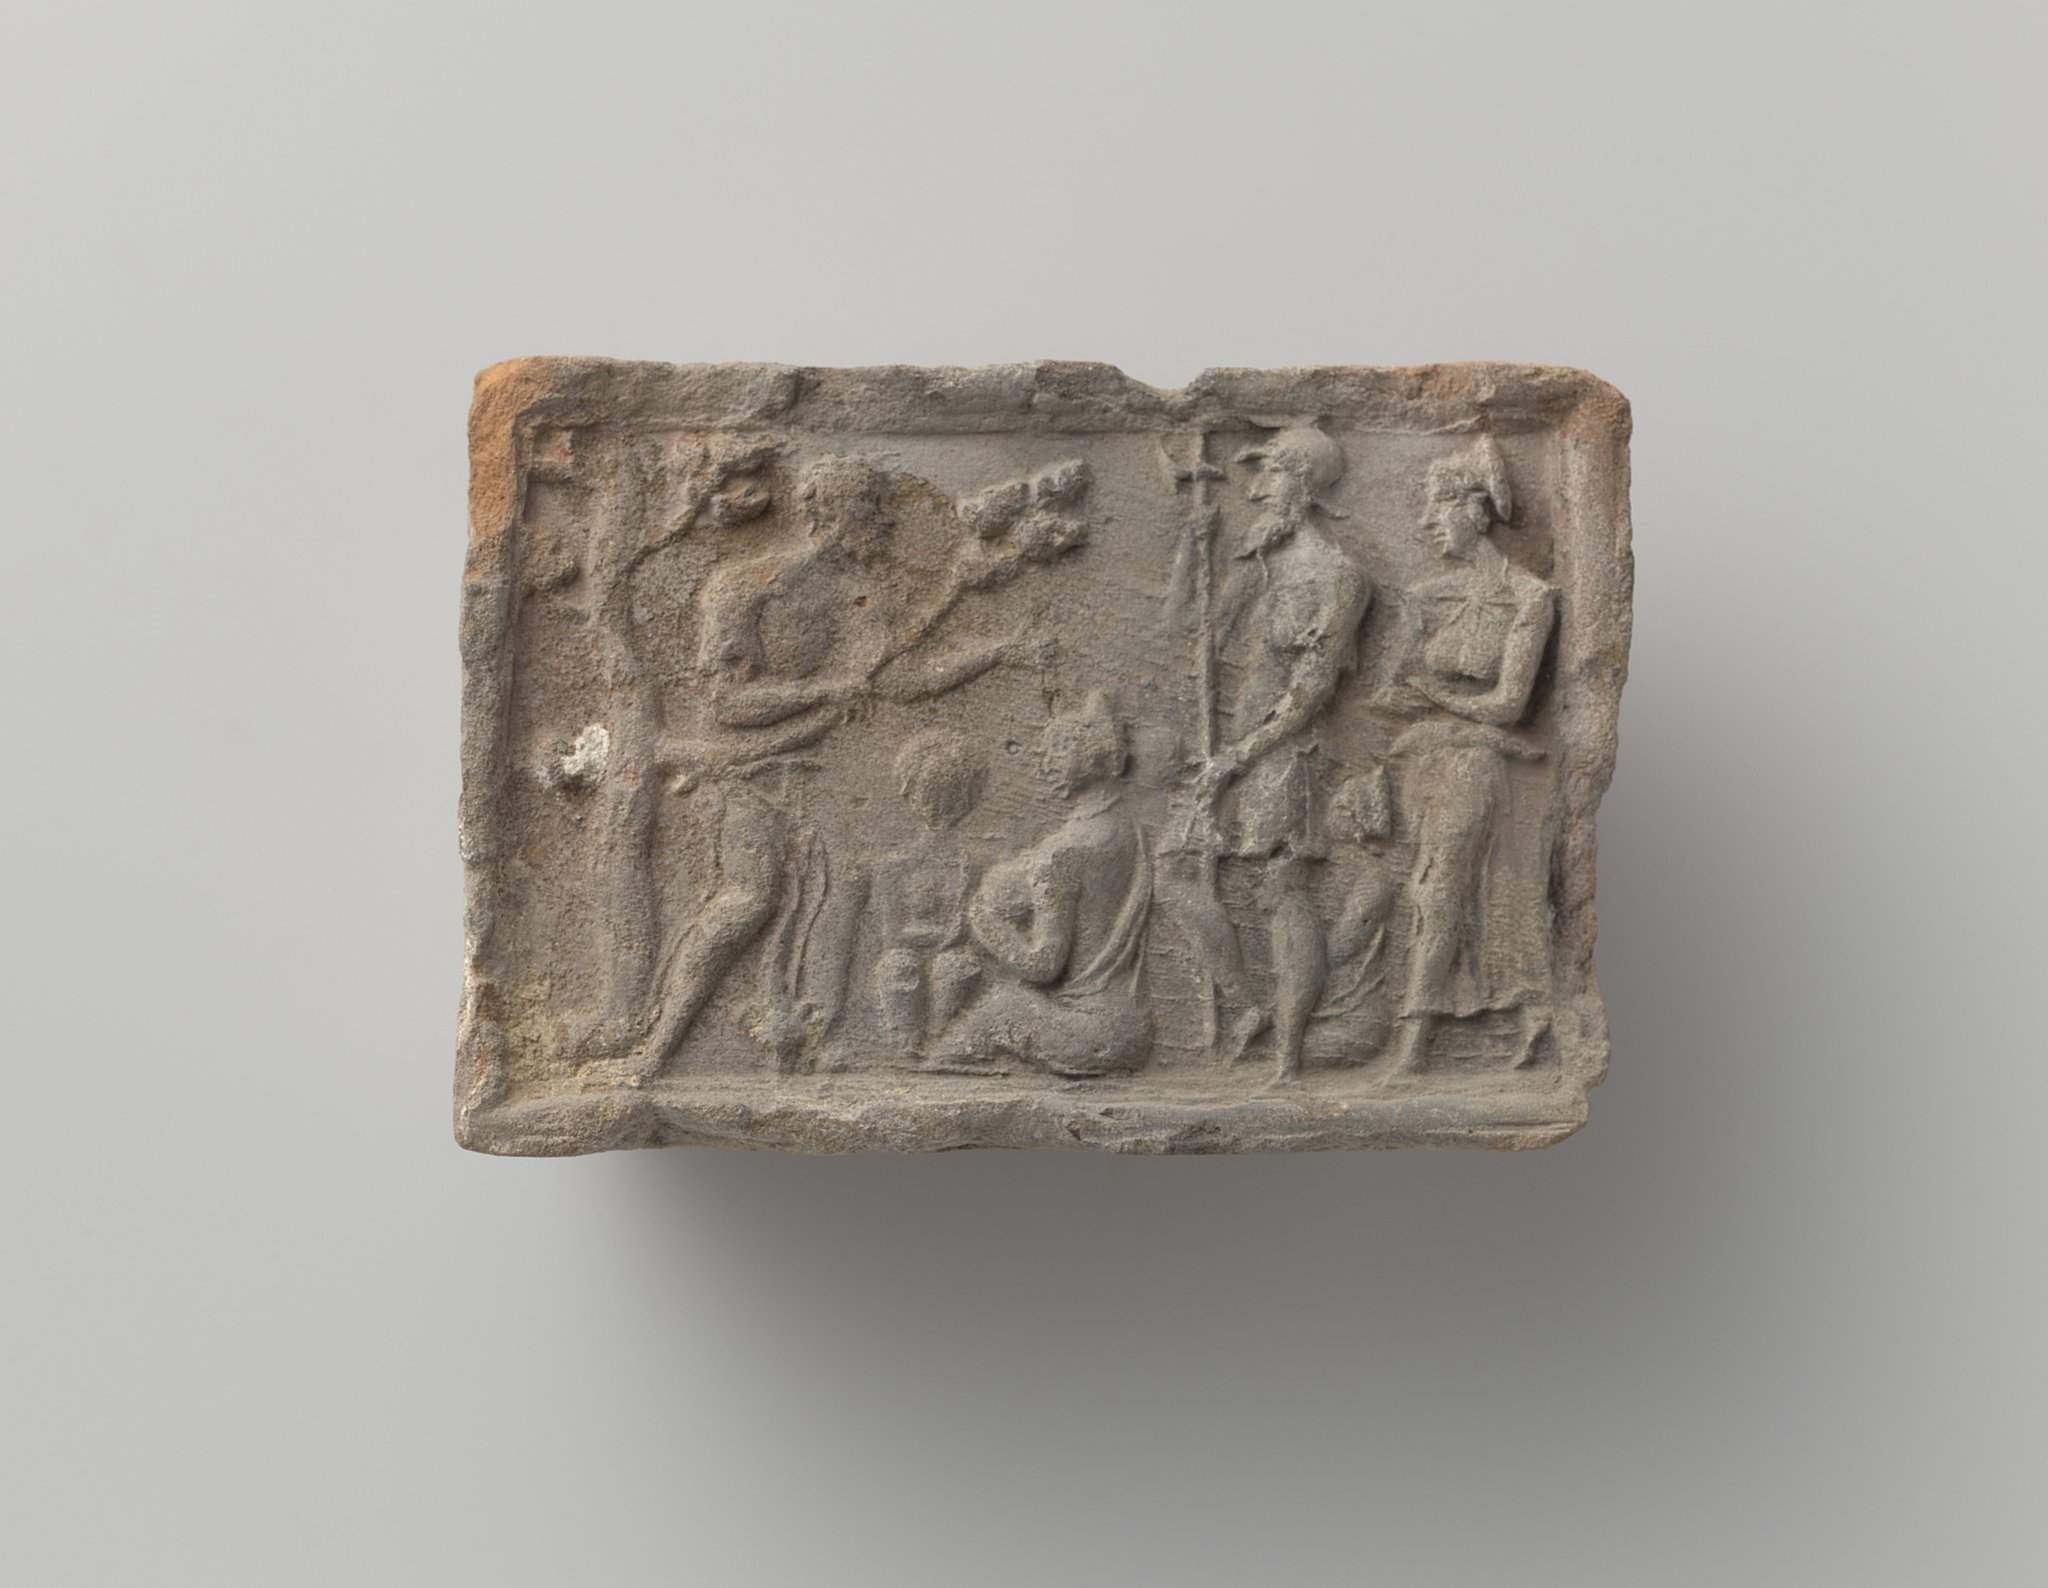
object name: hearthstone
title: Haardsteen met voorstelling van Johannes de Doper, predikend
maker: Anonymous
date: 1525-1575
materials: earthenware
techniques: firing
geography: southern netherlands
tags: john the baptist preaching (perhaps christ among the bystanders)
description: Haardsteen met een voorstelling van Johannes de Doper, predikend bij een boom. Naast hem drie zittende en twee staande figuren.